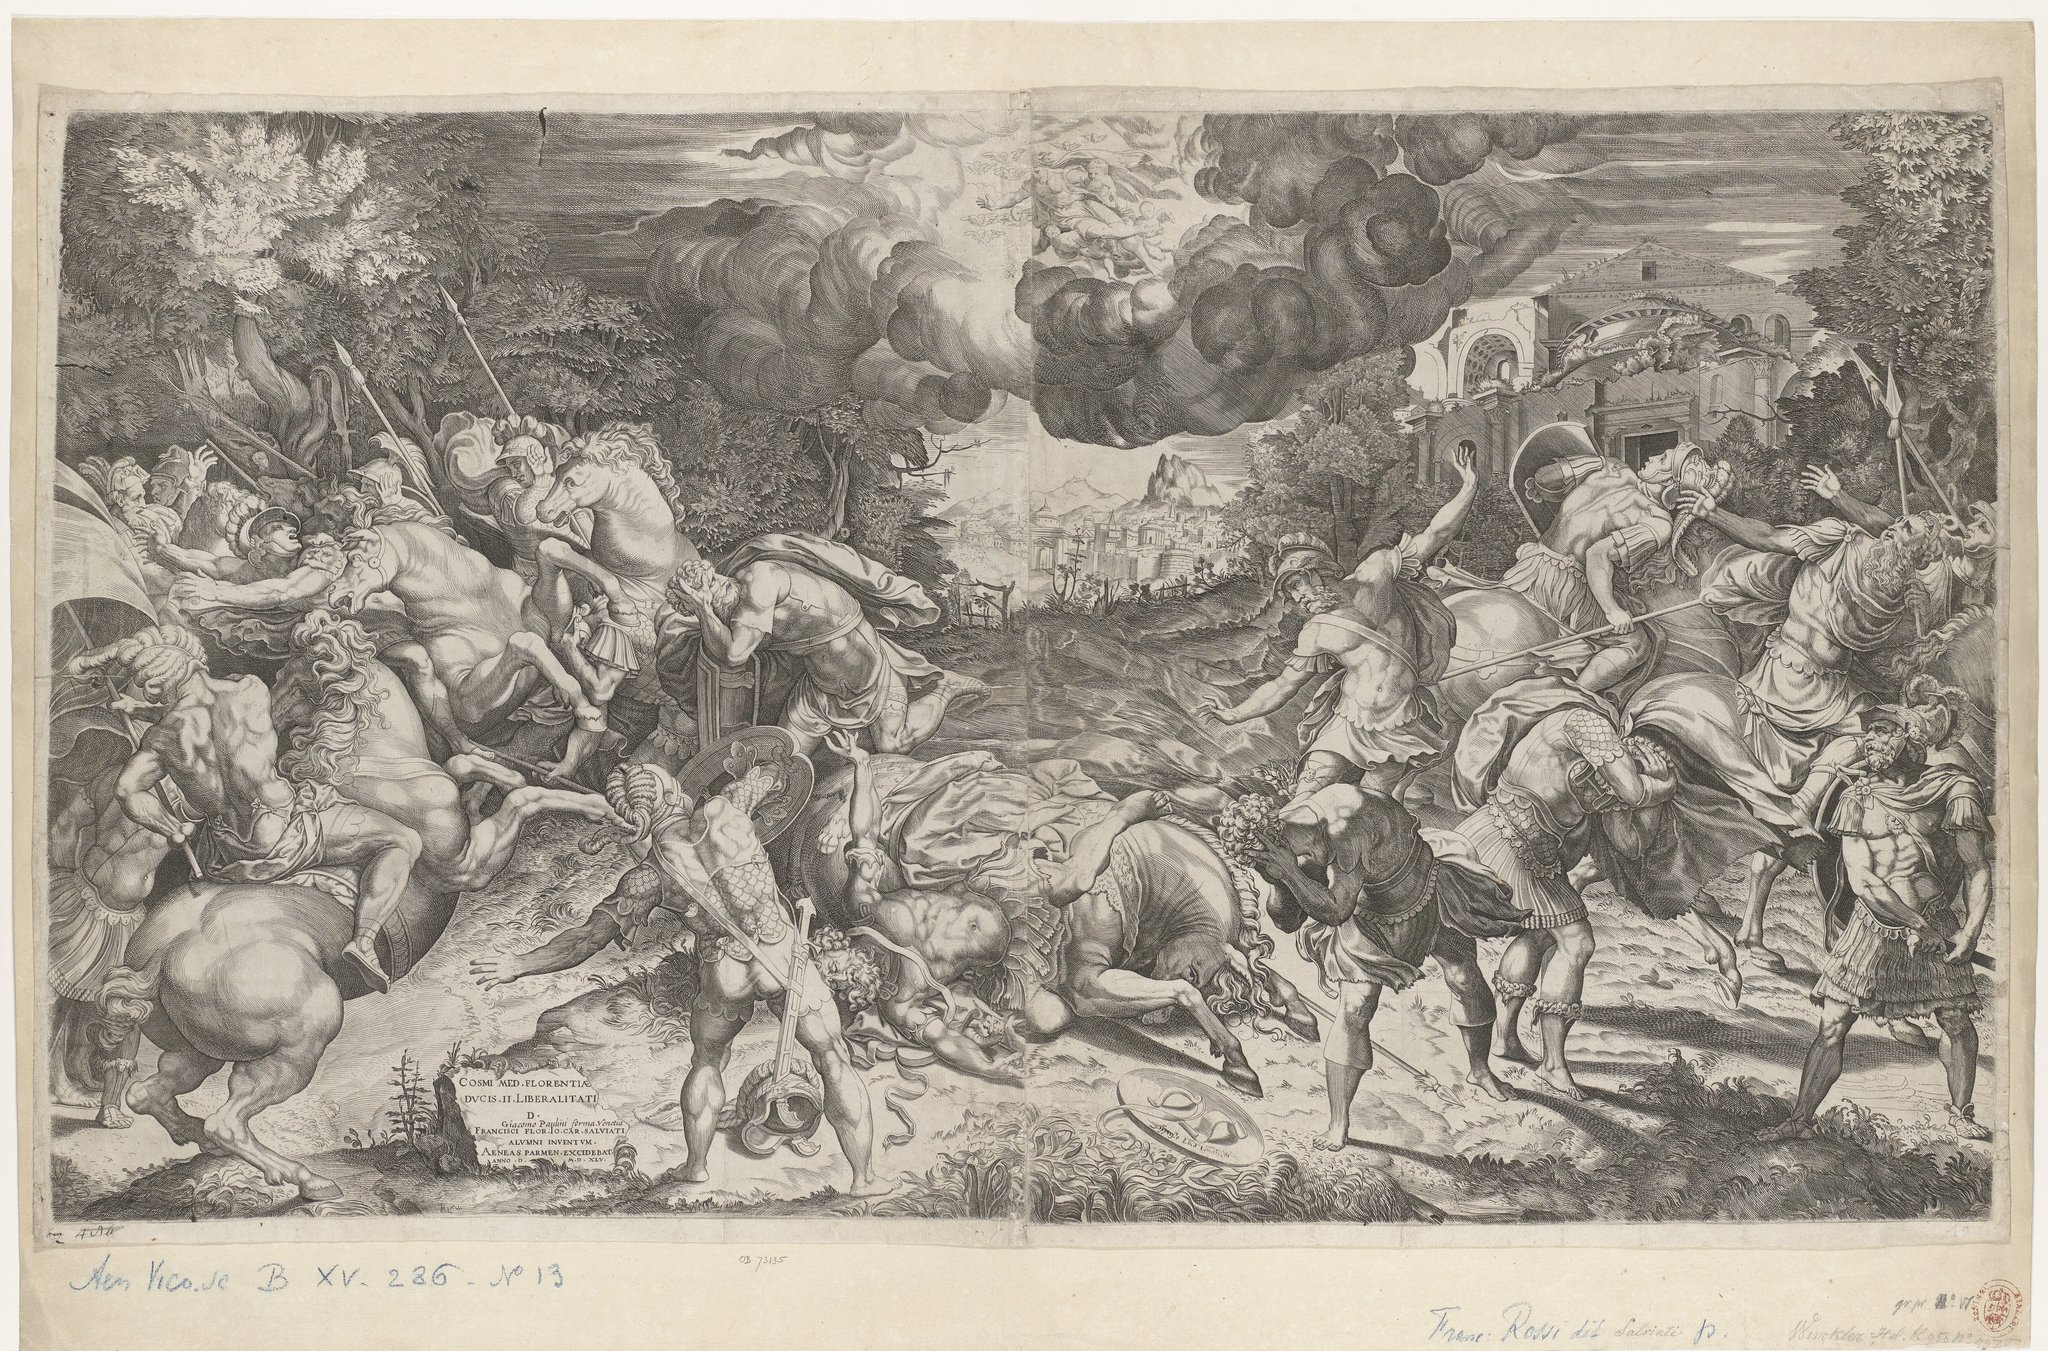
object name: print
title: Bekering van Paulus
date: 1545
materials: paper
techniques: engraving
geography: florence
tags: story of the conversion of paul (acts 9:1-18)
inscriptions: collector's mark: Lugt 240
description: Op weg naar Damascus valt Saulus geschrokken van zijn paard wanneer God aan hem verschijnt tussen de wolken. Zijn soldaten staan rondom hem in paniek. Op de achtergrond een landschap met ruïnes.